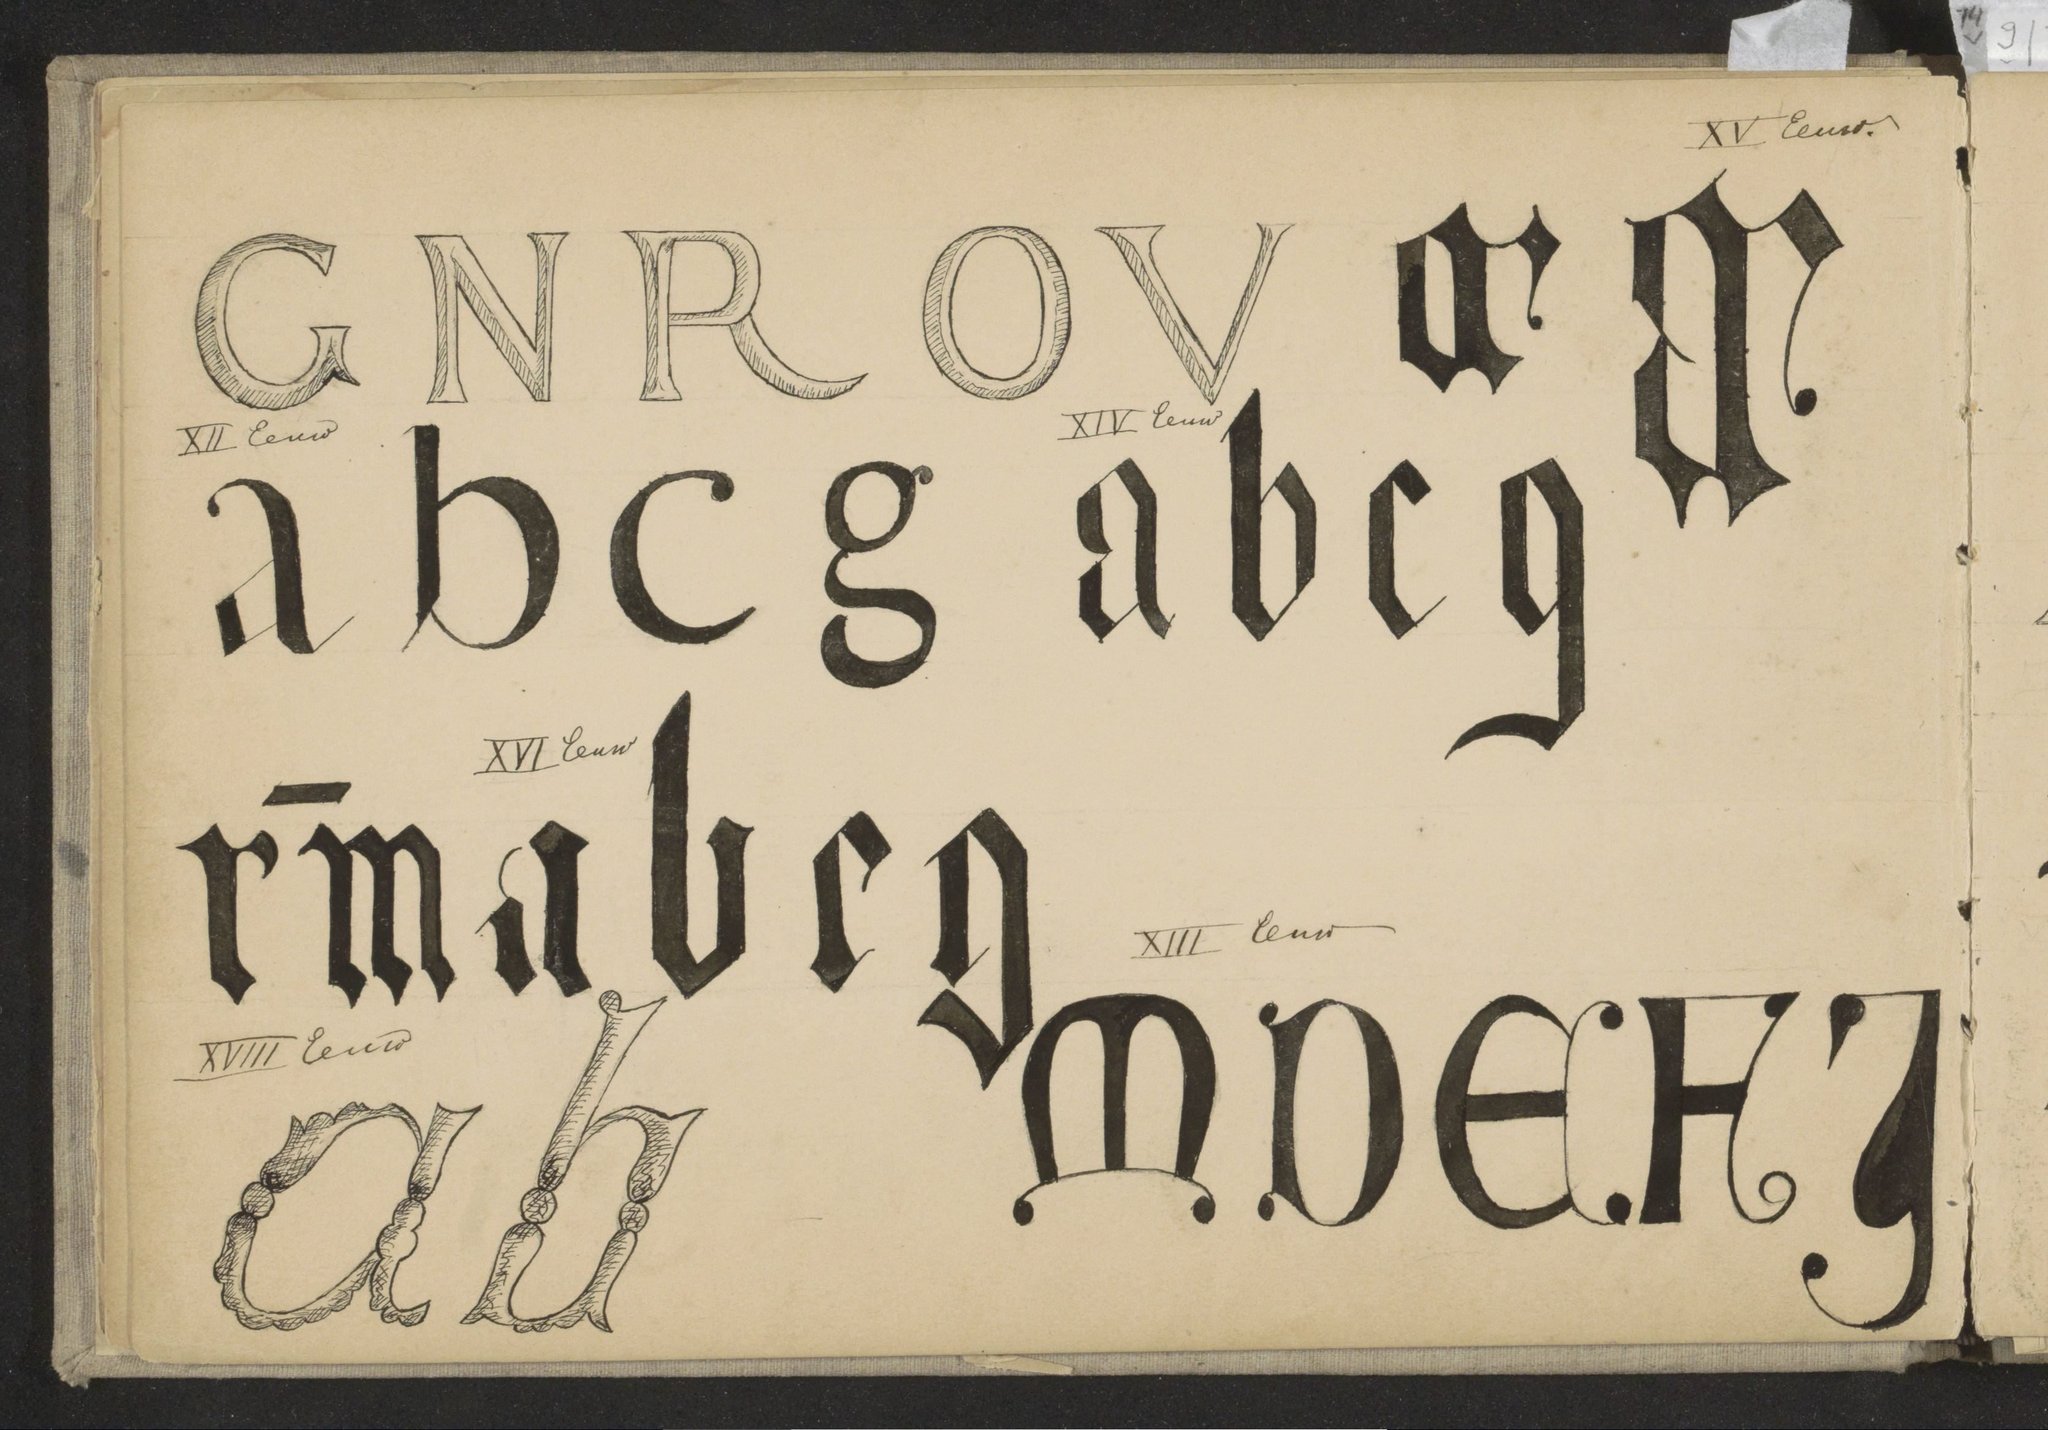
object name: sketchbook leaf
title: Kalligrafie: lettertypen uit de twaalfde tot en met de achttiende eeuw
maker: johanna van de kamer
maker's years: 1873-1922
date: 1890-1922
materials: ink, paper, pencil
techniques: pen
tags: calligraphy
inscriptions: annotation: ‘XV Eeuw/ XII Eeuw/ XIV Eeuw/ XVI Eeuw/ XVIII Eeuw/ XIII Eeuw’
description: Blad 7 verso uit een schetsboek met 43 bladen.